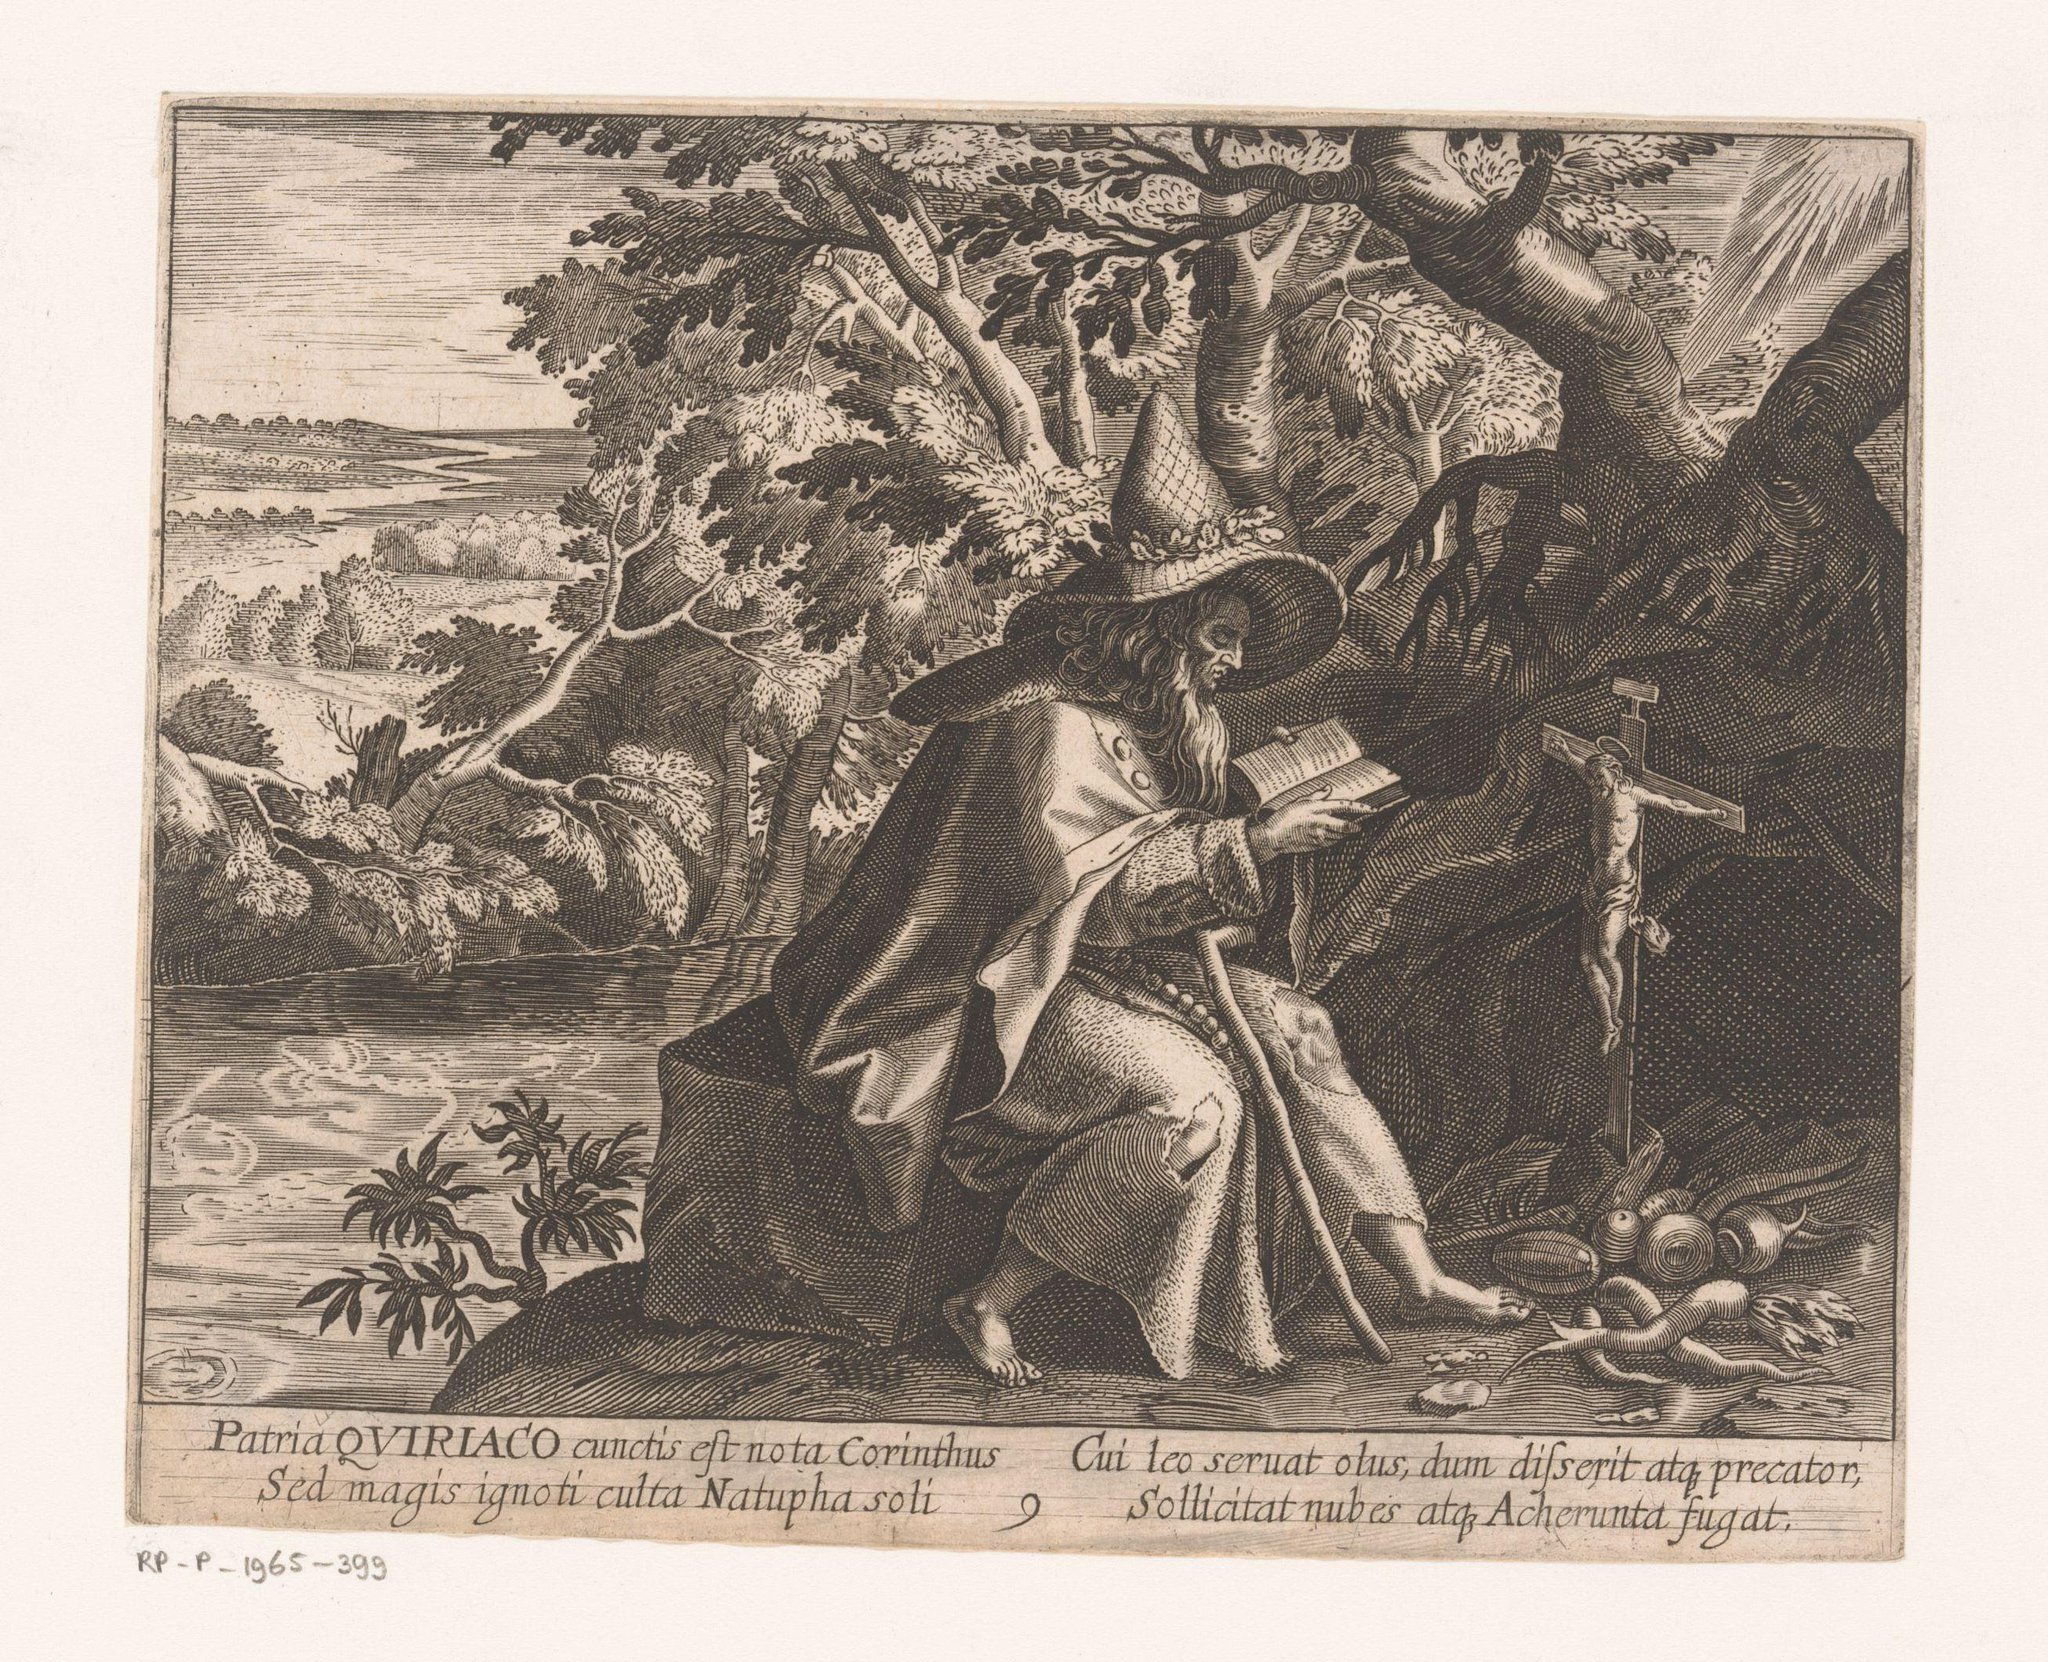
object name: print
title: Heilige Cyriacus de kluizenaar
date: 1594-1614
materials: paper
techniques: engraving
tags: forest, wood, anchorite, hermit, cave, grotto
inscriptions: collector's mark: Lugt 2228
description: Maakt deel uit van een 29-delige serie, over het leven van kluizenaars en heremieten naar prenten door Johann (I) en Raphaël Sadeler (I), naar ontwerp van Maerten de Vos, uitgegeven door Thomas de Leu.